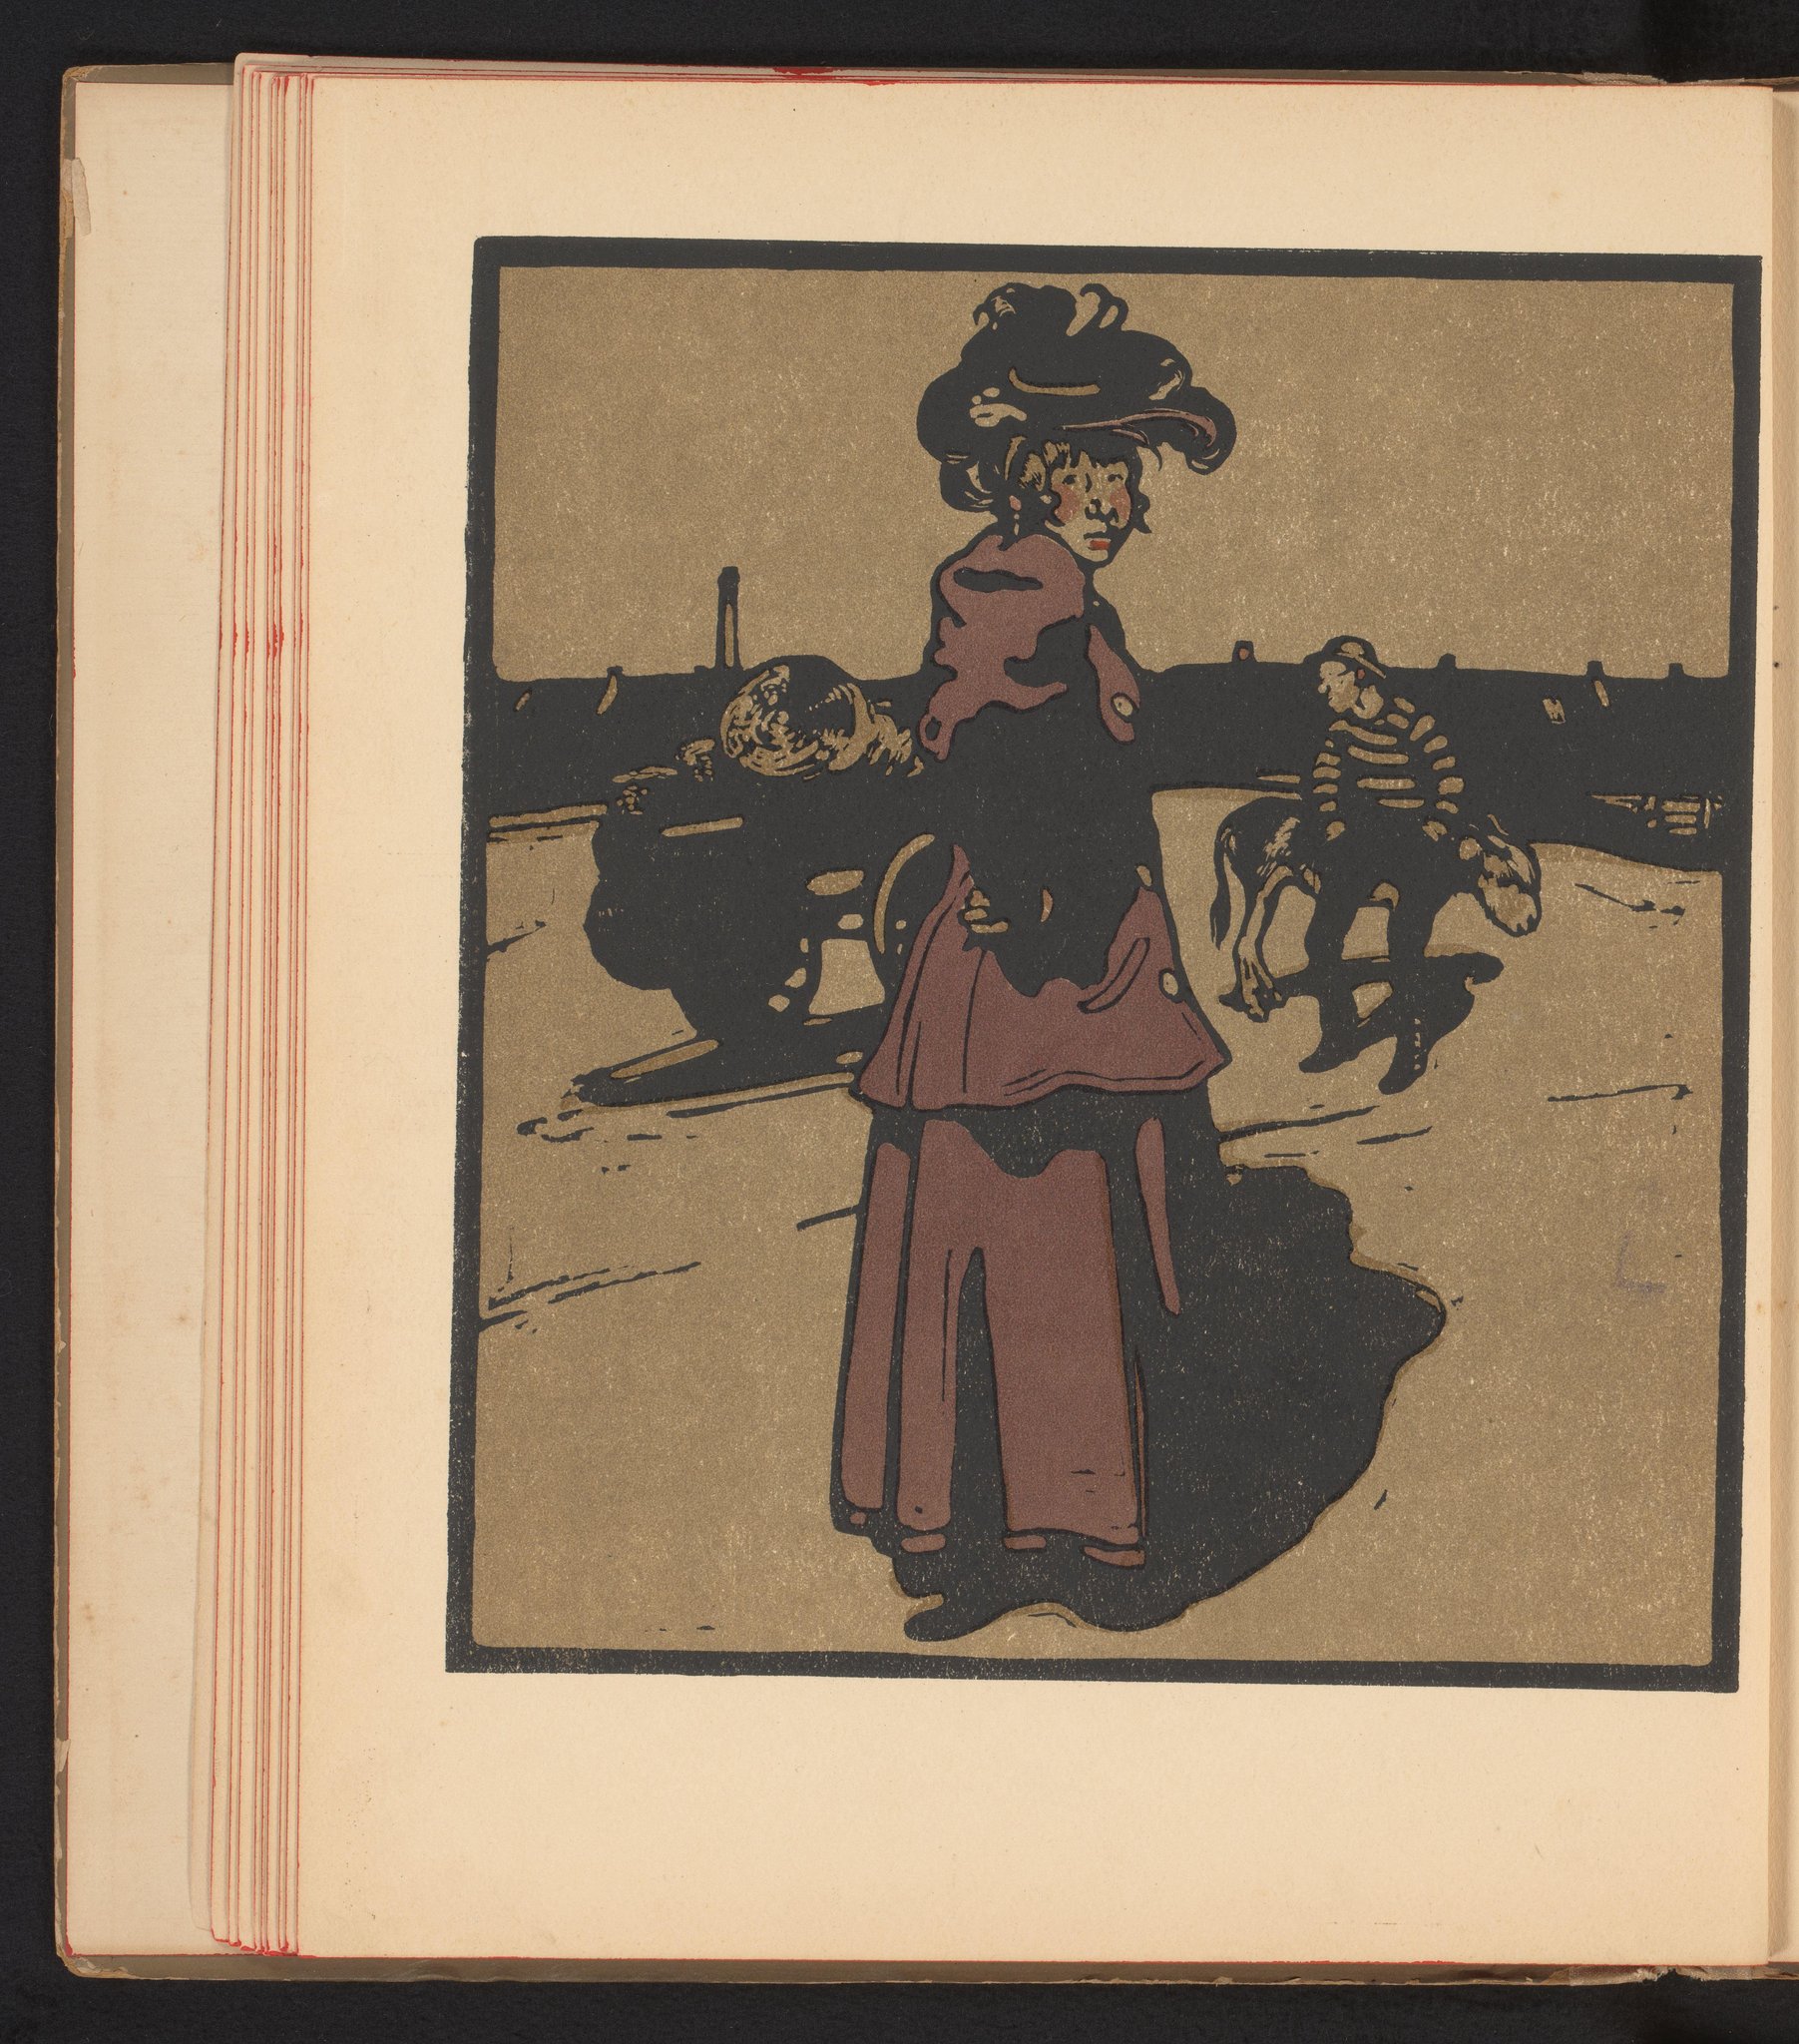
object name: page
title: Vrouw met hoed op straat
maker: william ernest henley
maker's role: criticus, dichter, redacteur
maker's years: 1849-1903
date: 1898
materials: paper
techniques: lithograph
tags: merchant, salesman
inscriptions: date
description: Lithografieën naar ontwerpen van houtsneden door William Nicholson. Sonnet in het Engels op de tegenoverliggende bladzijde.